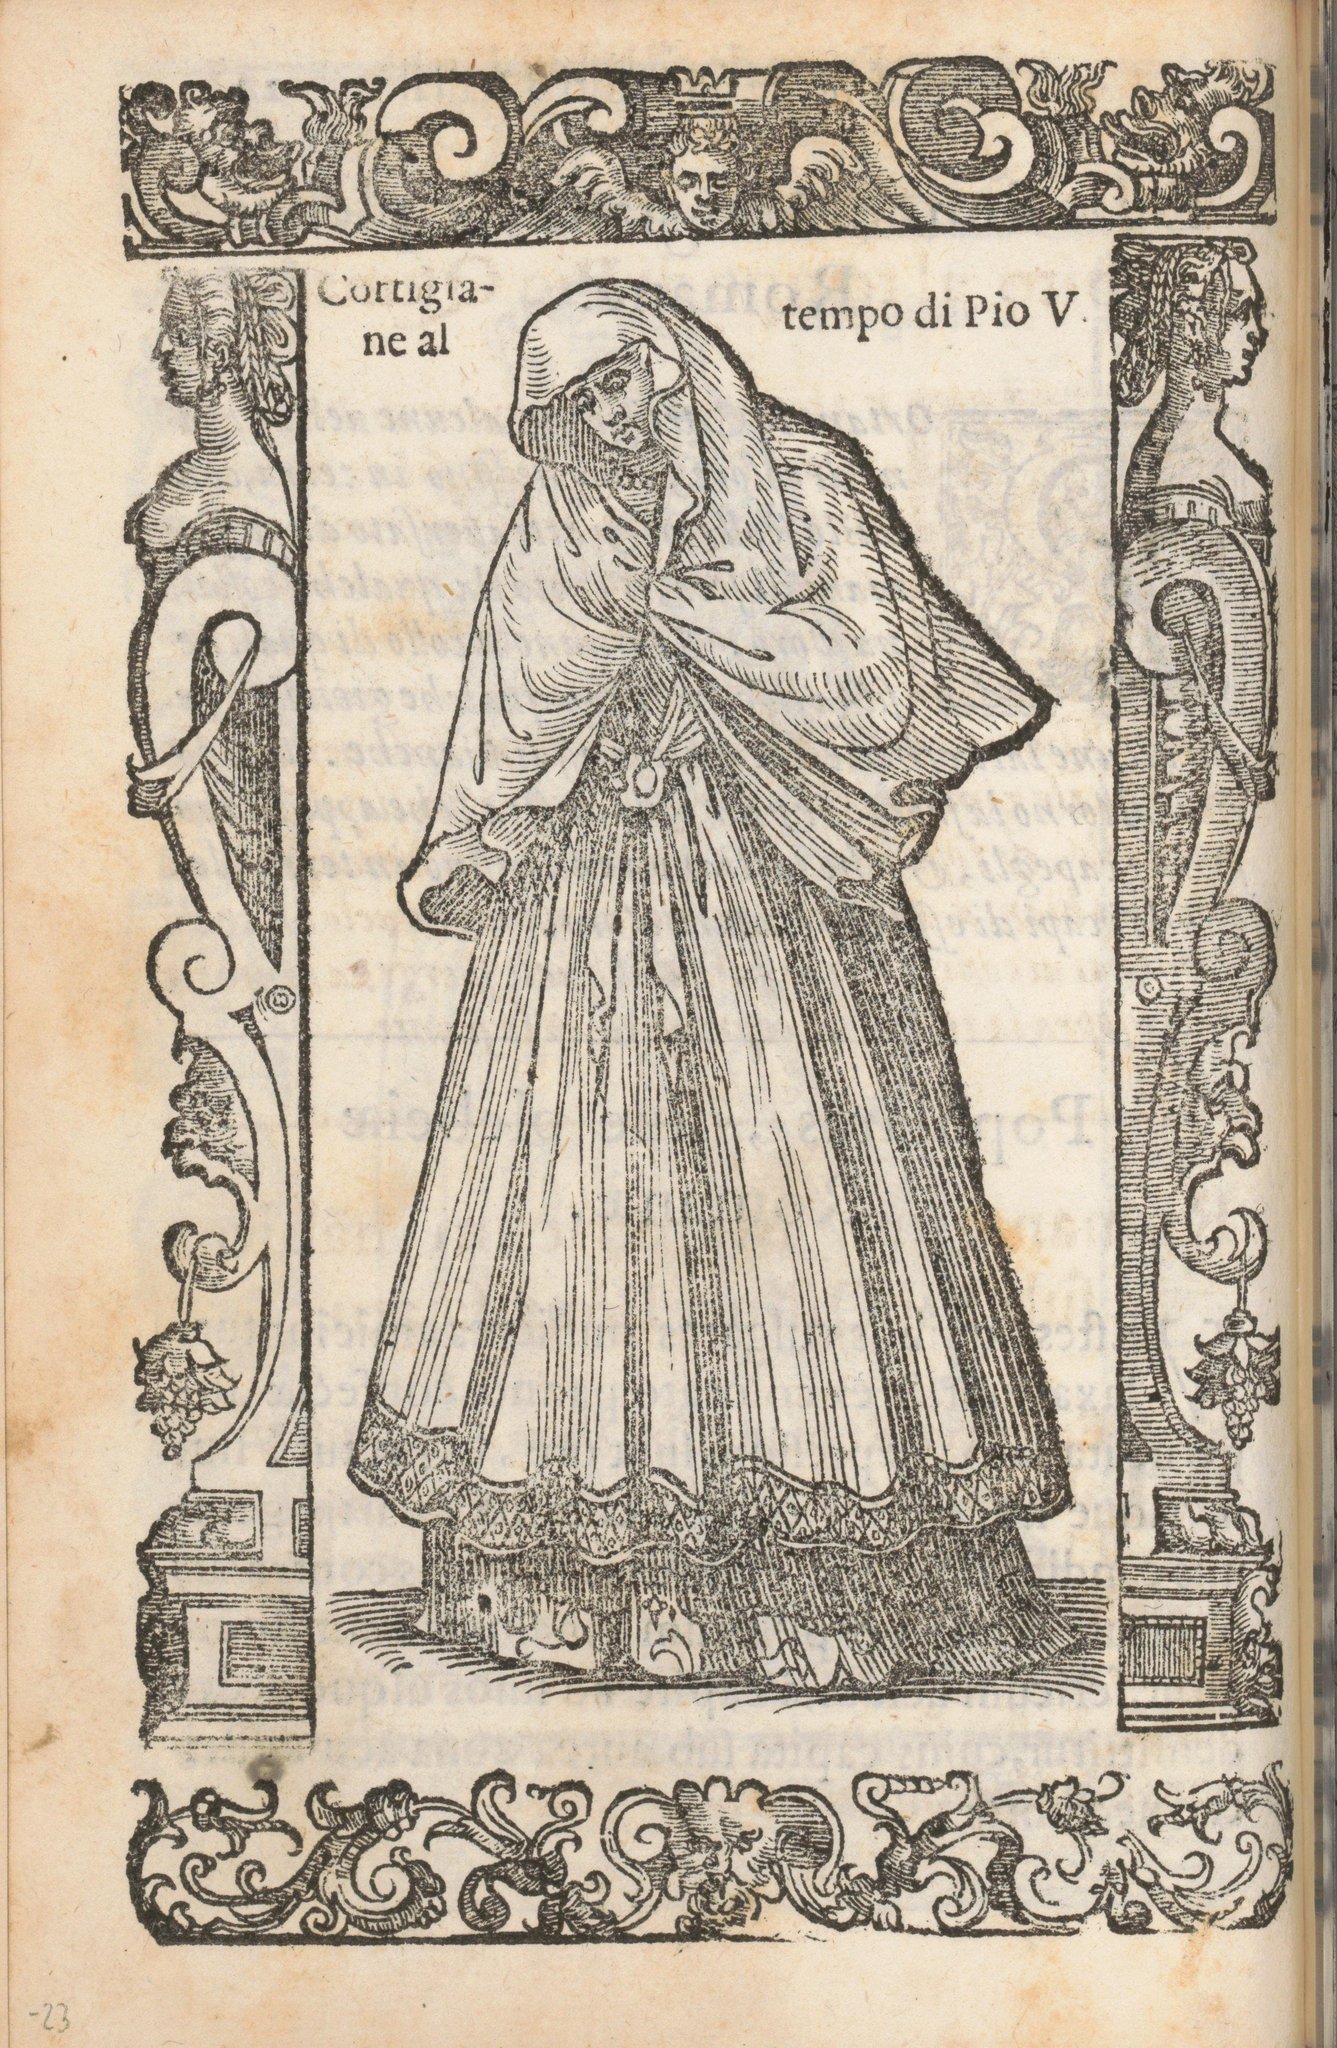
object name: costume print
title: Courtisane uit Rome in de tijd van paus Pius V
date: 1598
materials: paper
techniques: woodcut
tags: veil (+ women's clothes), fashion plates, dress, gown (+ women's clothes), whore, prostitute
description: Courtisane of prostitué uit Rome, in de tijd van paus Pius V, volgens Vecellio herkenbaar aan de kleding. Zij draagt een zijden 'sottana' die tot op de grond valt. Daaroverheen mocht zij een overkleed dragen dat iets korter was dan de sottane (zimarra genaamd) Het was van zwarte stof (zoals de mantels van de weduwen) Over het hoofd een sluier die tot op de schouders valt en het voorhoofd bedekt. Op die manier gekleed onderscheidden courtisanes zich in Rome van de respectabele Romeinse dames. In ornamentrand.